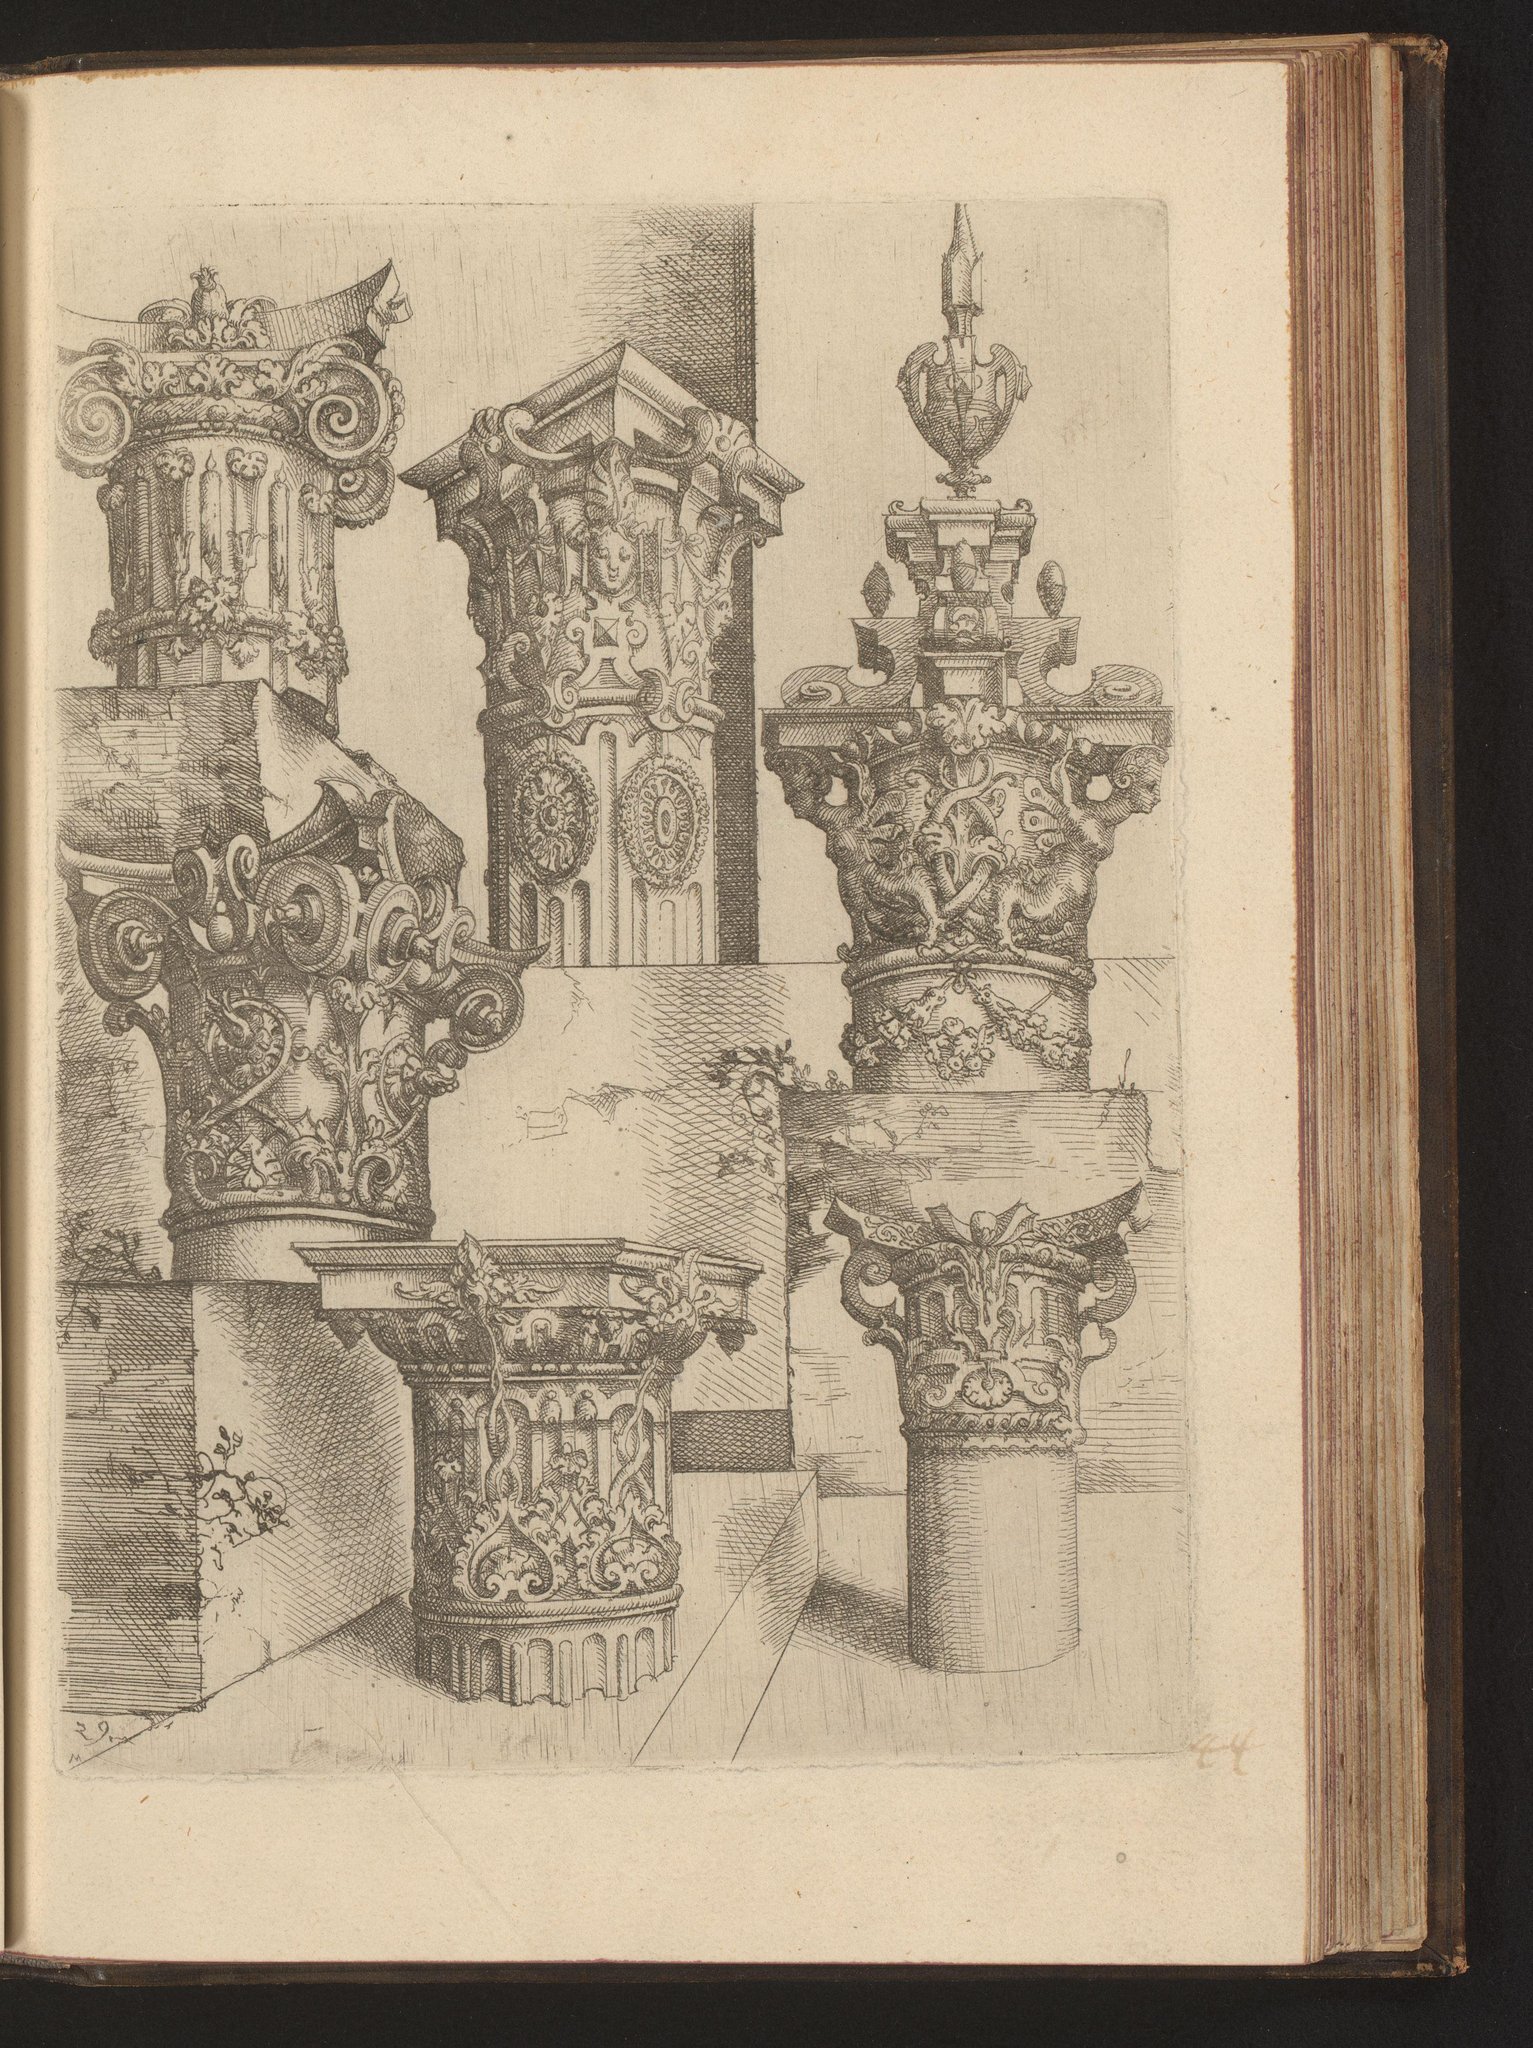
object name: page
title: Architectura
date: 1593-1595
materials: paper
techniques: etching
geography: straatsburg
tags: ornament ~ hybrid beings; human and animal forms mixed, composite order ~ architecture, column, pillar ~ architecture, other architectural details, ornament ~ festoon, garland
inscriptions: collector's mark: Lugt 2760, collector's mark: Lugt 2228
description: Prent gebruikt in: Dietterlin, Wendel (I). Architectura de quinq[ue] columnarum simmetrica distributione et variis eorundem or namentis: Liber I. Straatsburg: Bernhard Jobin, 1593.